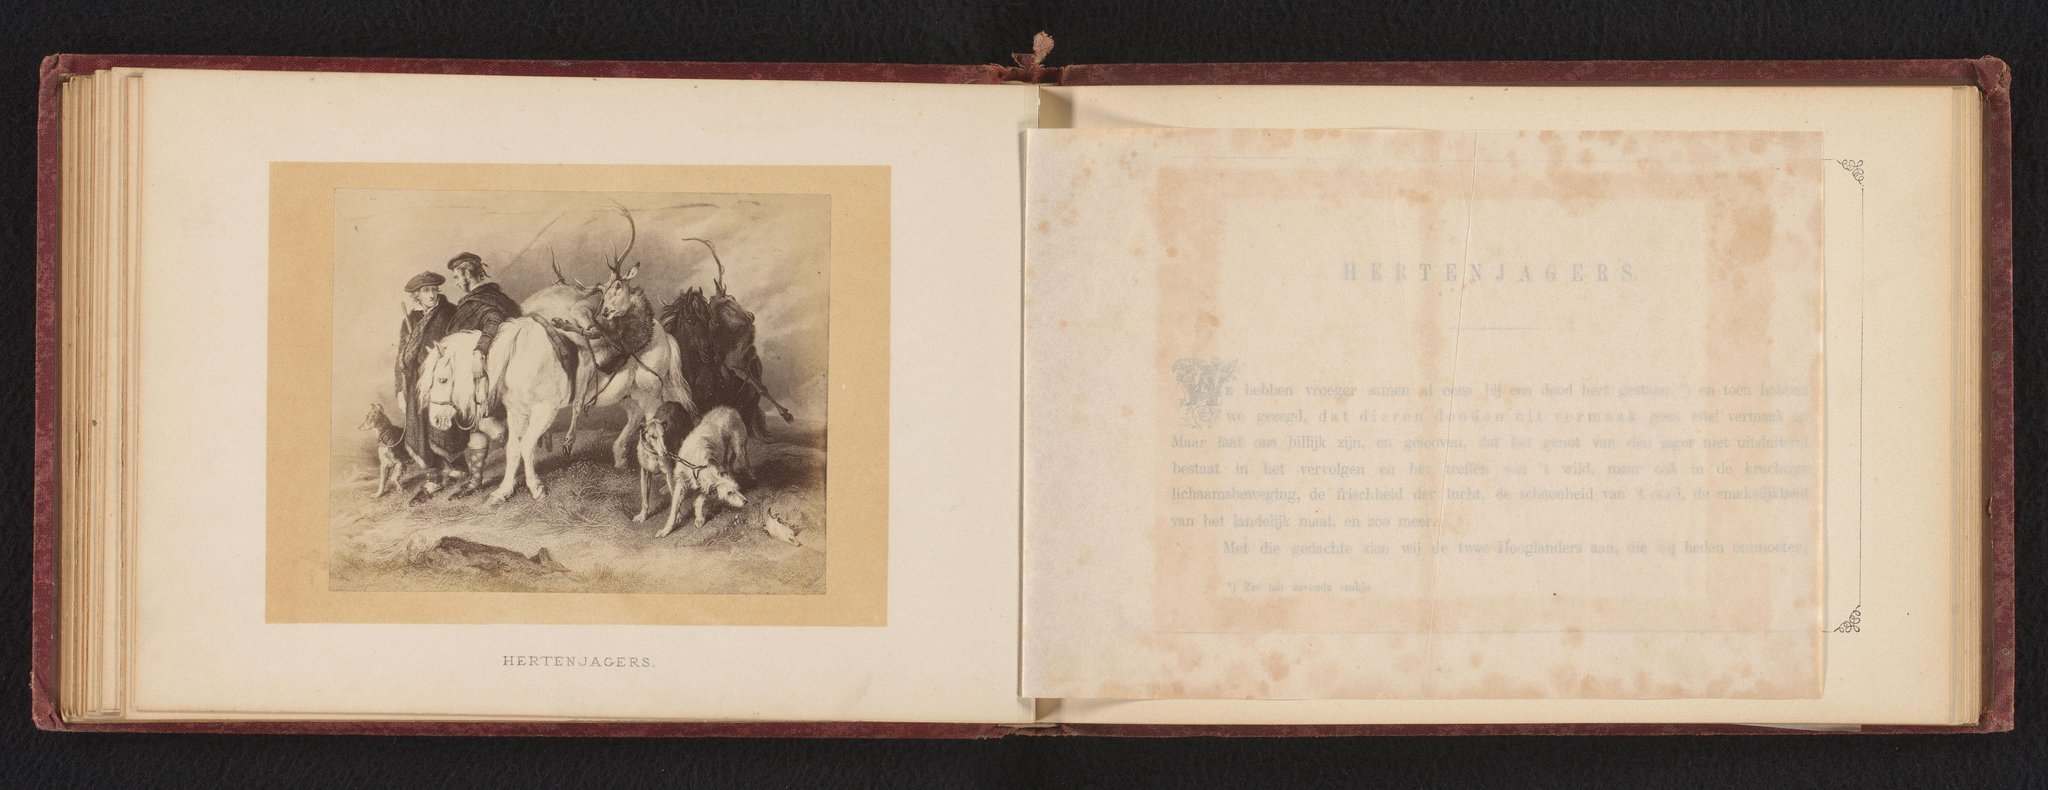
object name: page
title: Fotoreproductie van de gravure Hertenjagers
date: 1872-1875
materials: paper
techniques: albumen print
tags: print, e.g.: engraving, etching, lithograph, return from the hunt